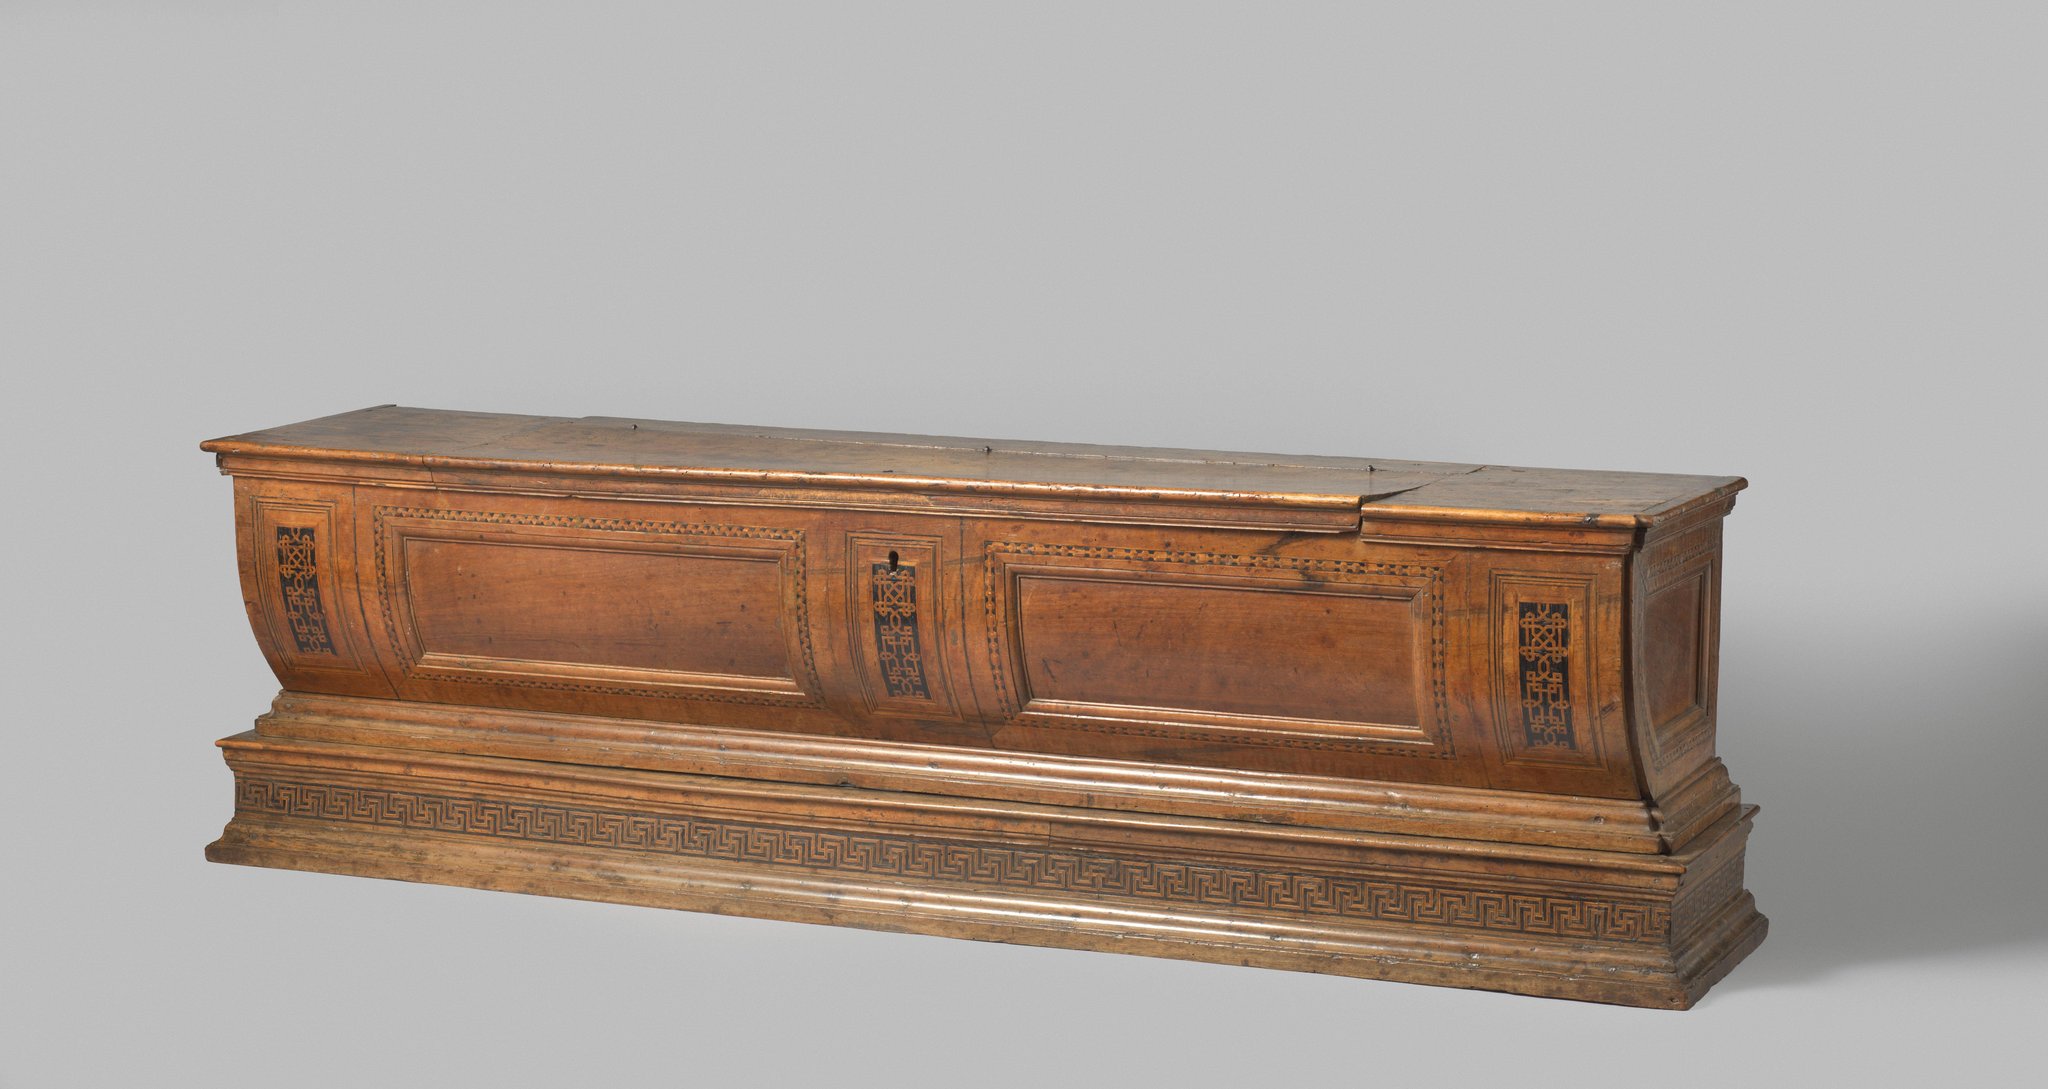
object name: chest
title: Bank van notenhout met binnenwerk van populierenhout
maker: Anonymous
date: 1500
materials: wood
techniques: intarsia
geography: florence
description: Bank van notenhout met binnenwerk van populierenhout en versierd met intarsia. In het voetstuk een fries met meanderrand in intarsia. De voorzijde is licht bolvormig gebogen en vertoont op de hoeken en in het midden een licht vooruitspringend veld, waartussen twee gladde panelen; dit alles binnen profiellijsten en door intarsia-randen omgeven. Het middendeel vormt de kistdeksel. De zijwanden hebben gladde panelen. Zie tevens BK-16632 en BK-NM-12354.